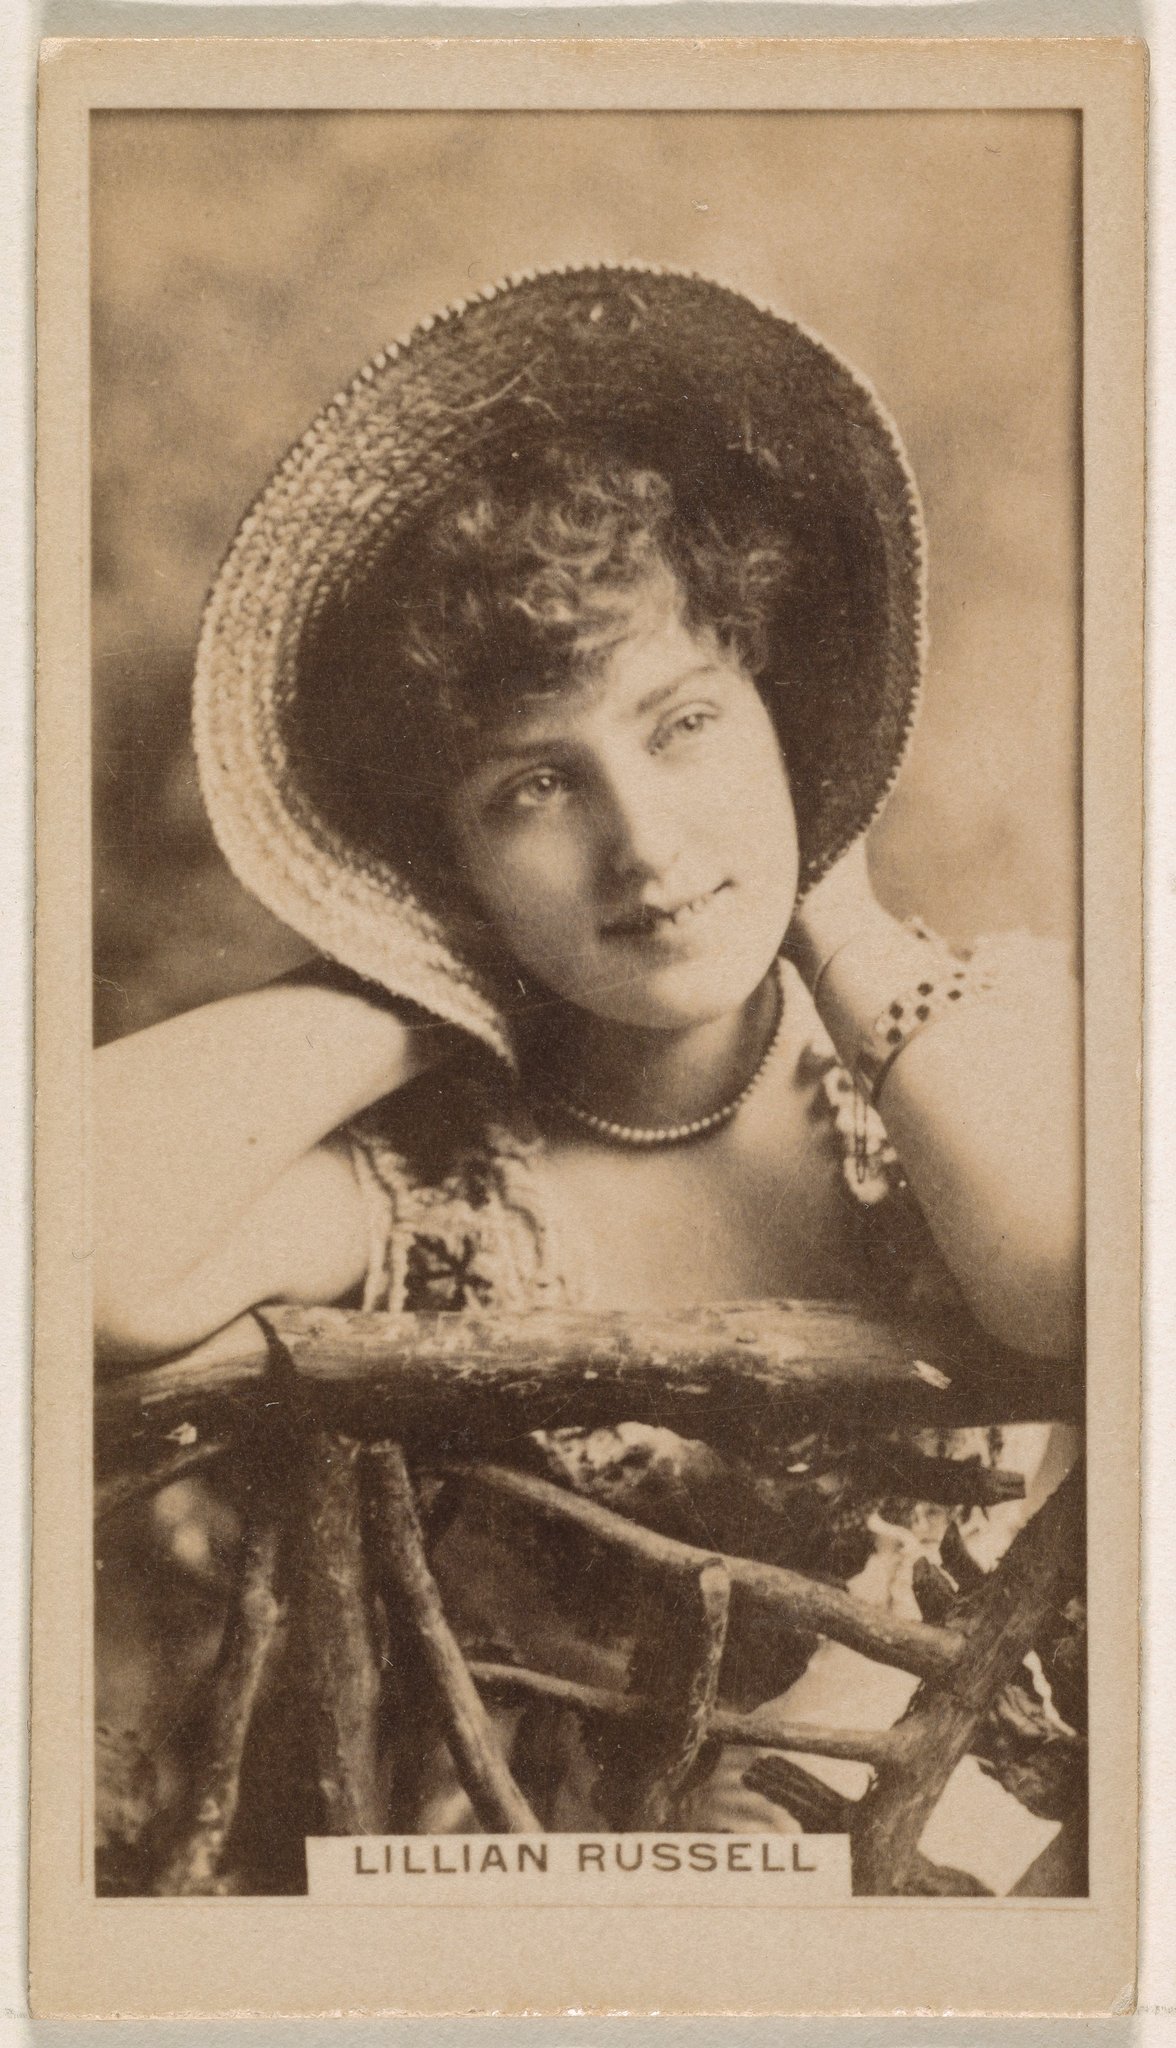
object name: photograph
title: Lillian Russell, from the Actresses series (N245) issued by Kinney Brothers to promote Sweet Caporal Cigarettes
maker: kinney brothers tobacco company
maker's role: publisher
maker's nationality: american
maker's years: 1869-2011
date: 1890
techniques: albumen silver print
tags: portraits,women,actresses